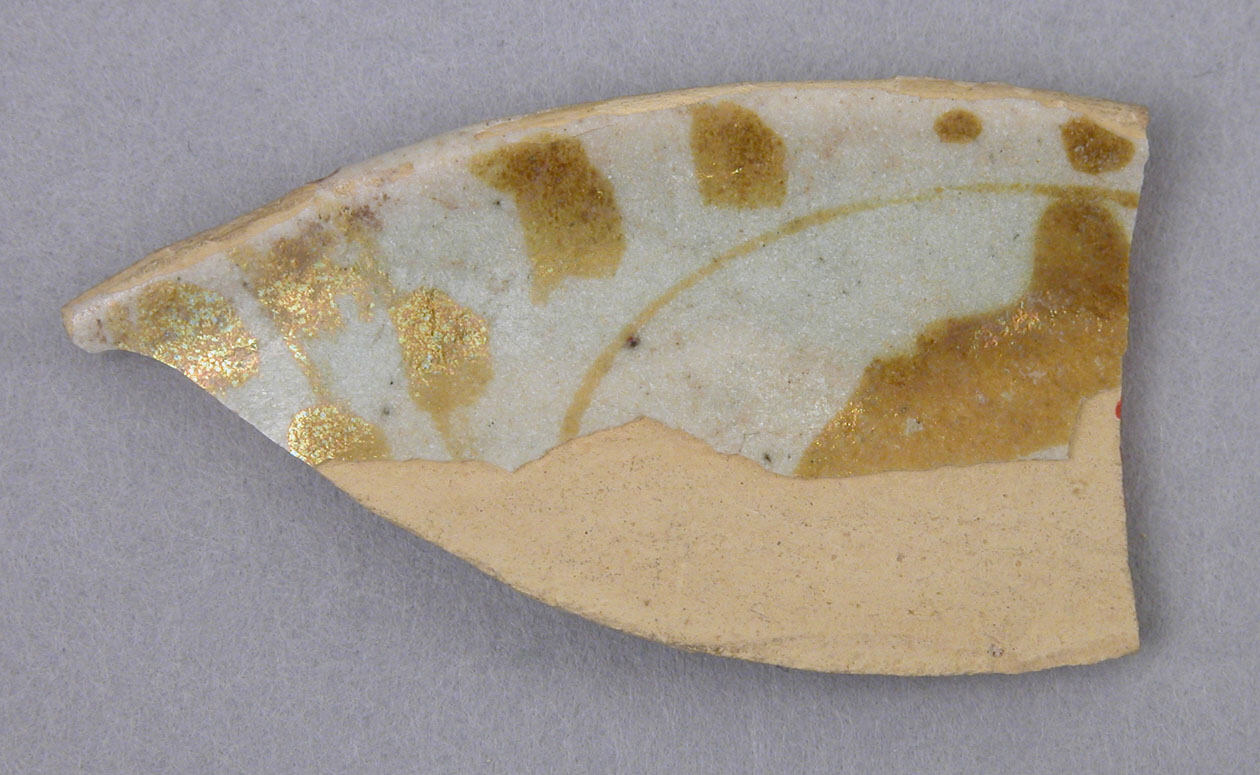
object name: fragment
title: Fragment of a Luster-Painted Bowl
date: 801-1000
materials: earthenware, glaze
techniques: luster painting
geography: iraq